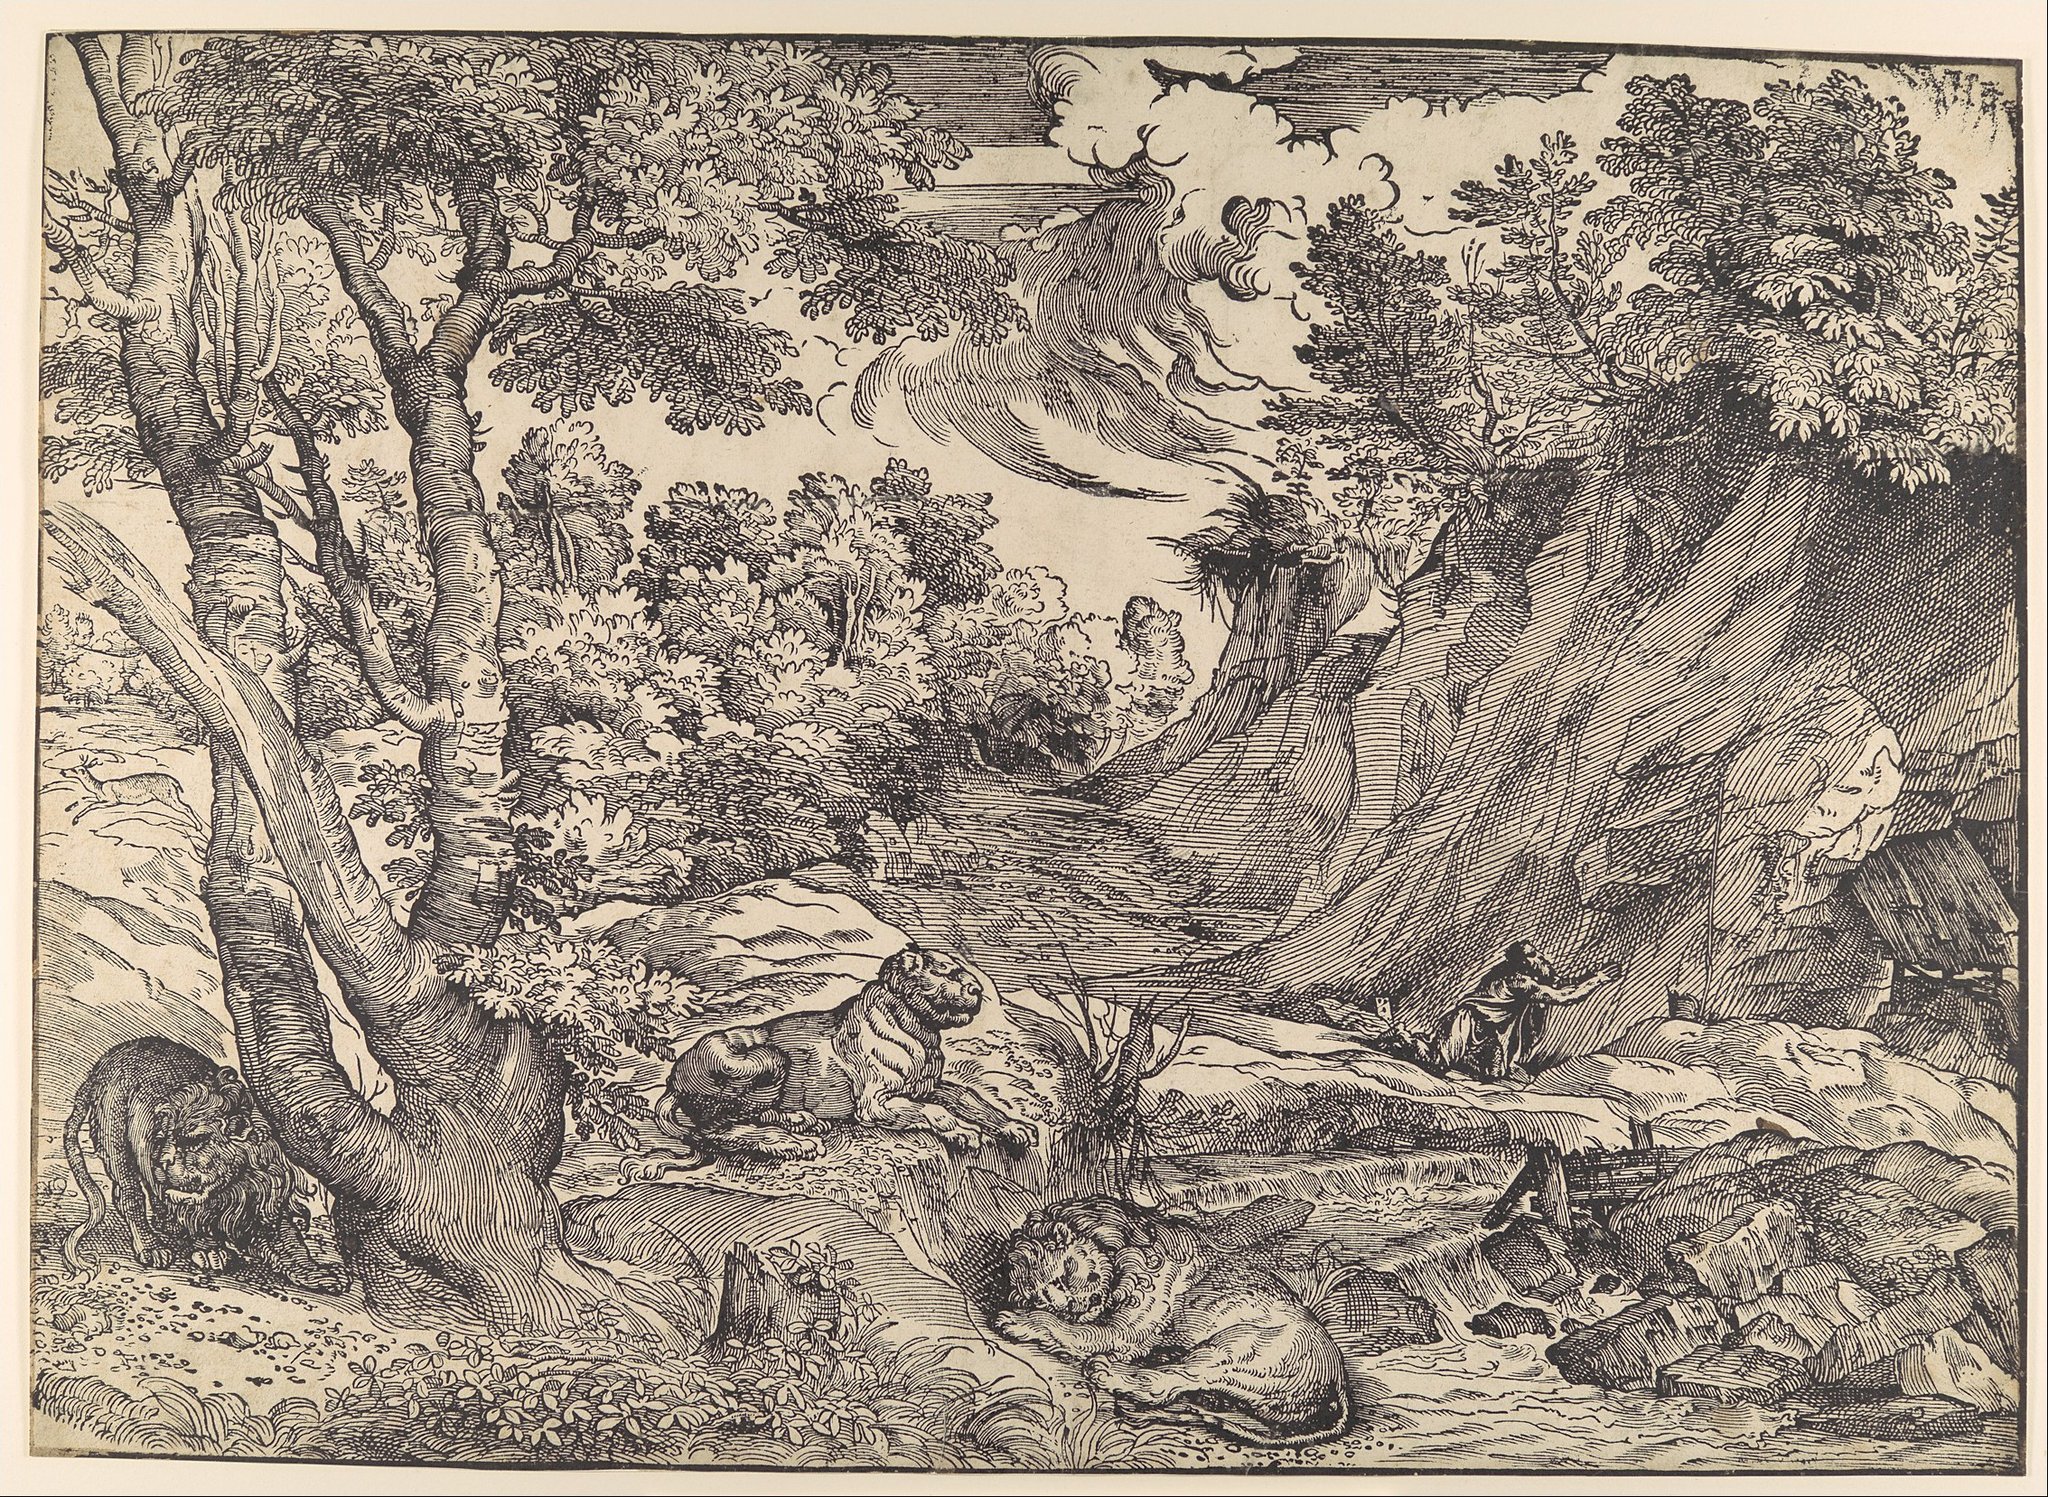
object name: print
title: St. Jerome in the Wilderness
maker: nicolò boldrini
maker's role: artist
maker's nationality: italian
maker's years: 1500-1566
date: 1534-1566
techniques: woodcut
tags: lions,landscapes,saint jerome